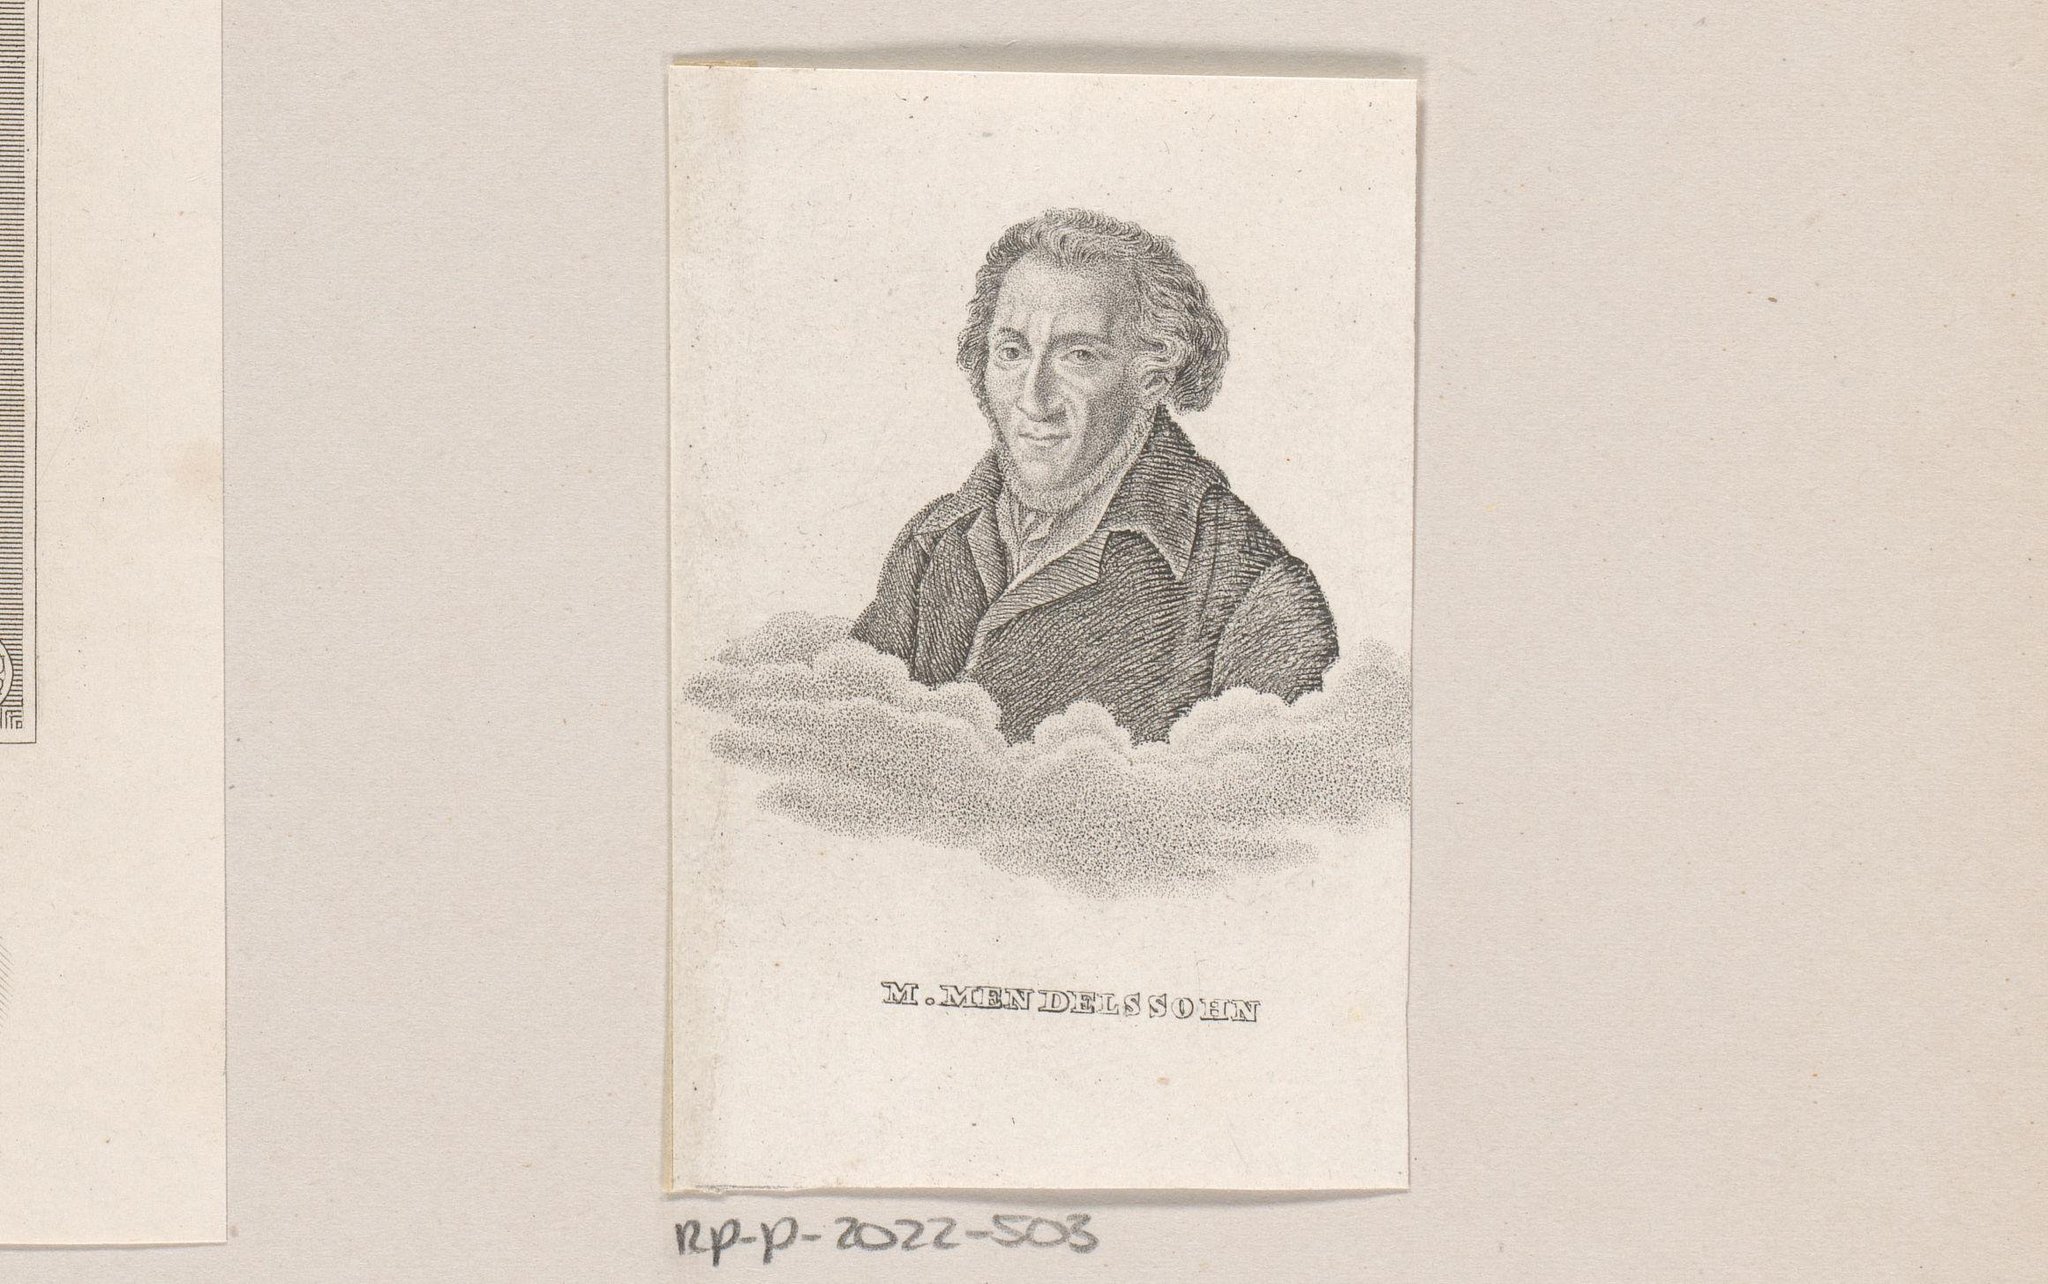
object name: print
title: M. Mendelssohn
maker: Anonymous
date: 1760-1900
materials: paper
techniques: engraving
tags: historical persons